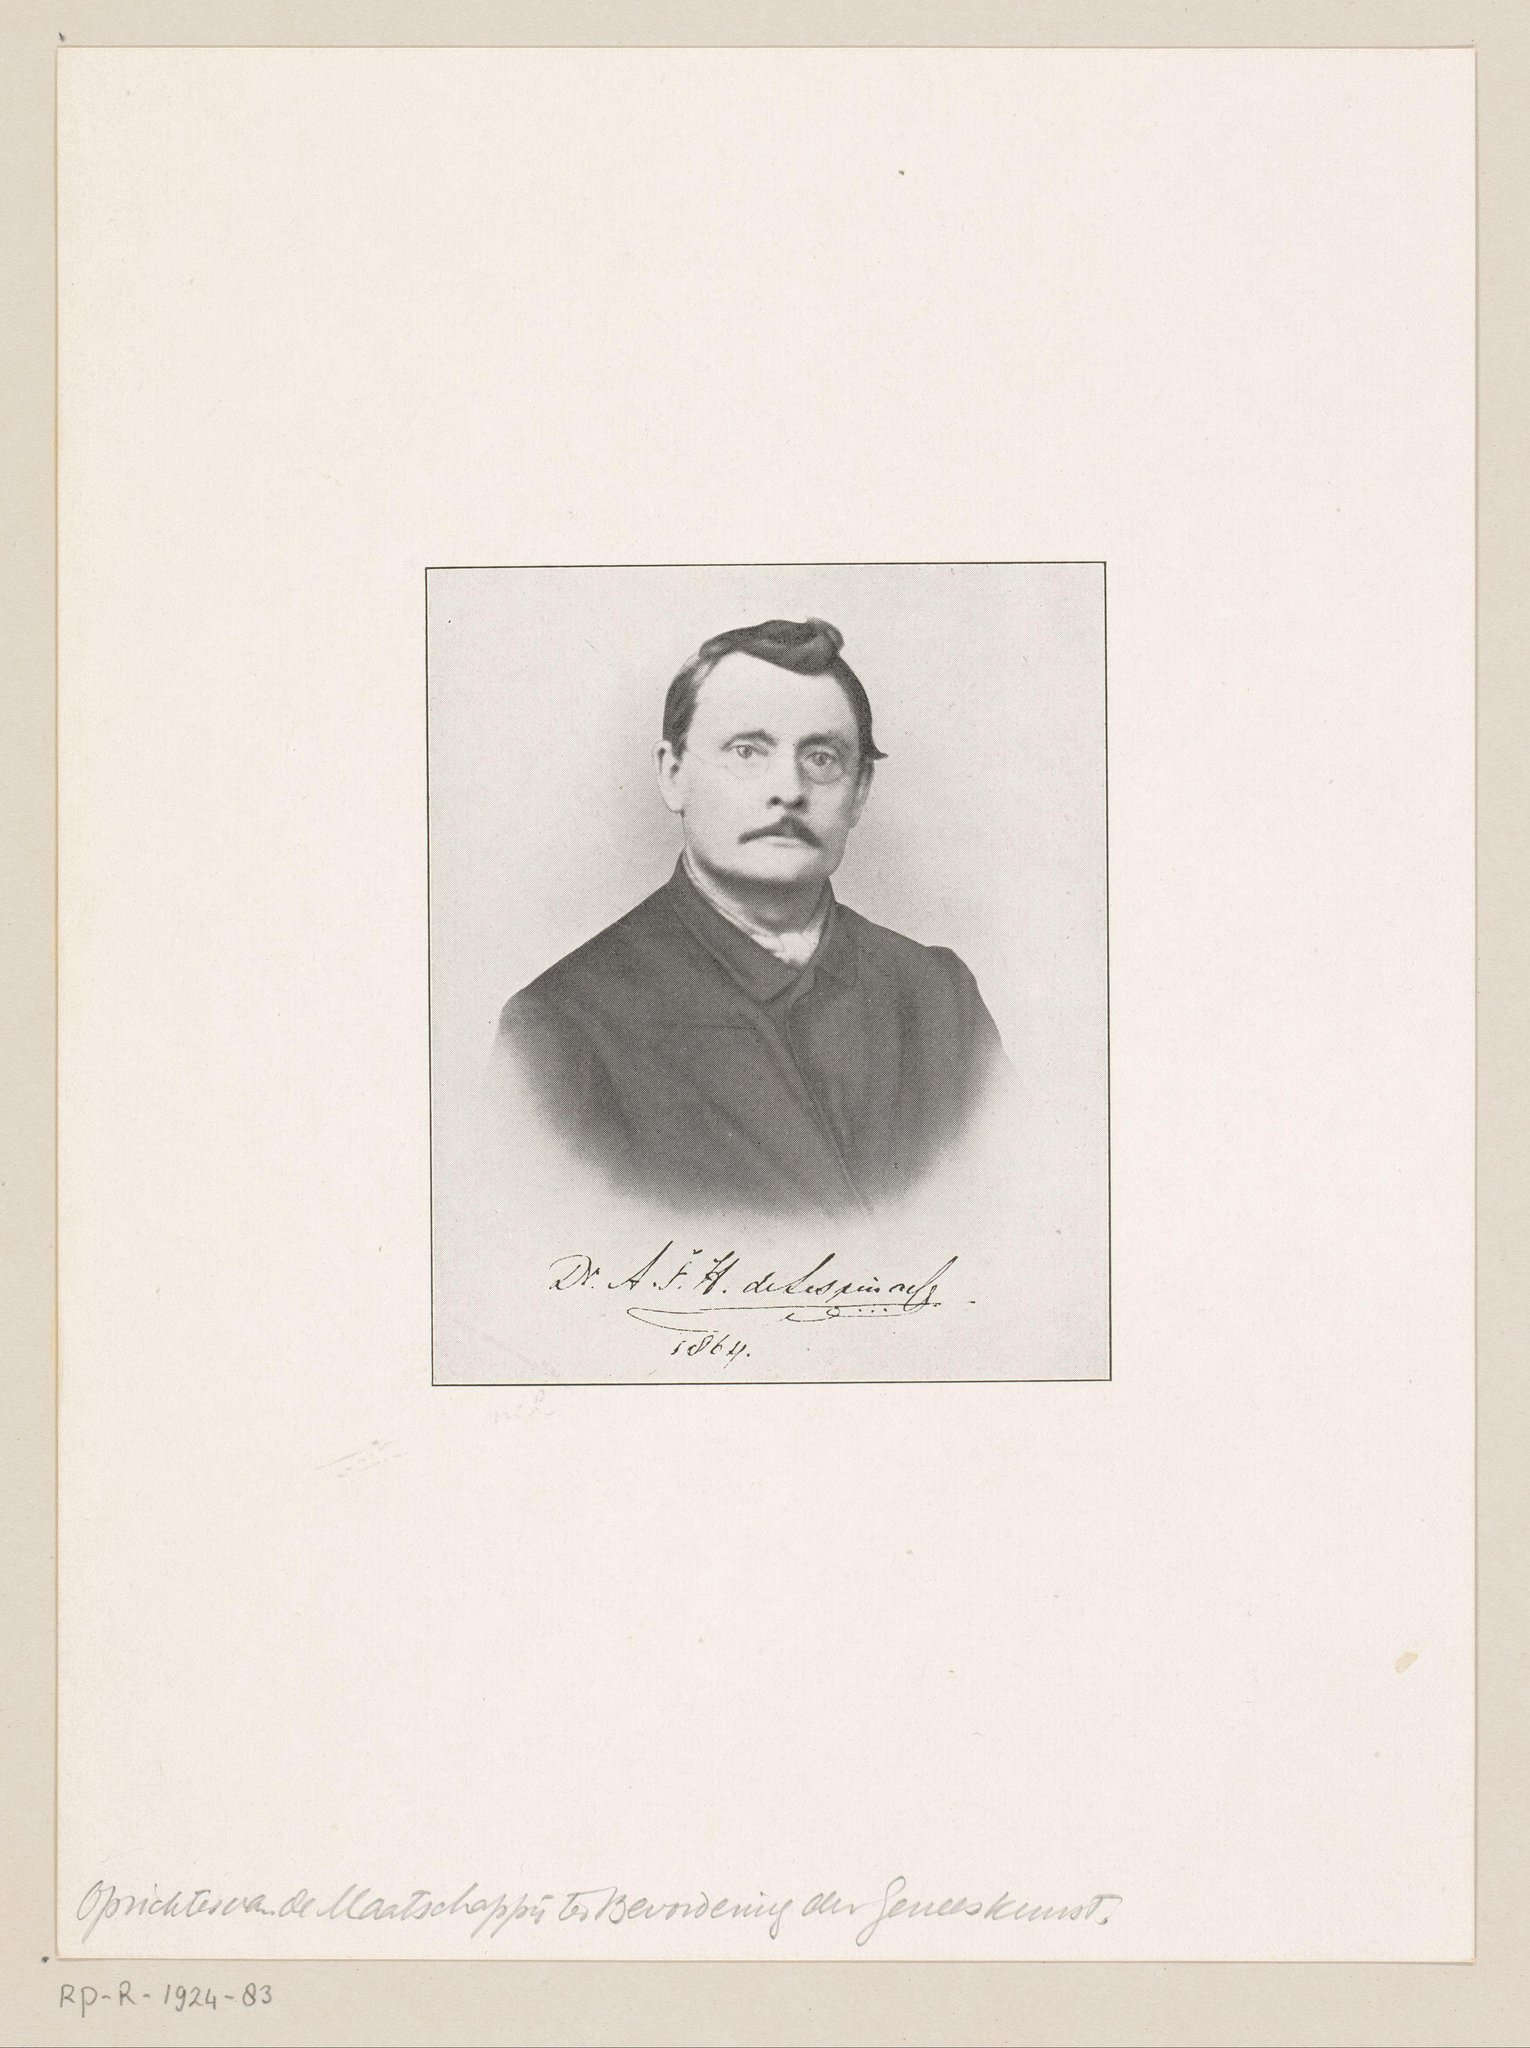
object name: photomechanical print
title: Portret van Adolph Frederik Henri de Lespinasse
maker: Anonymous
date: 1864-1924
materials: paper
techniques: autotype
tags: delft, historical persons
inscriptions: collector's mark: Lugt 2233, inscription: ‘Oprichter van de Maatschappj ter Bevordering der Geneeskunst’